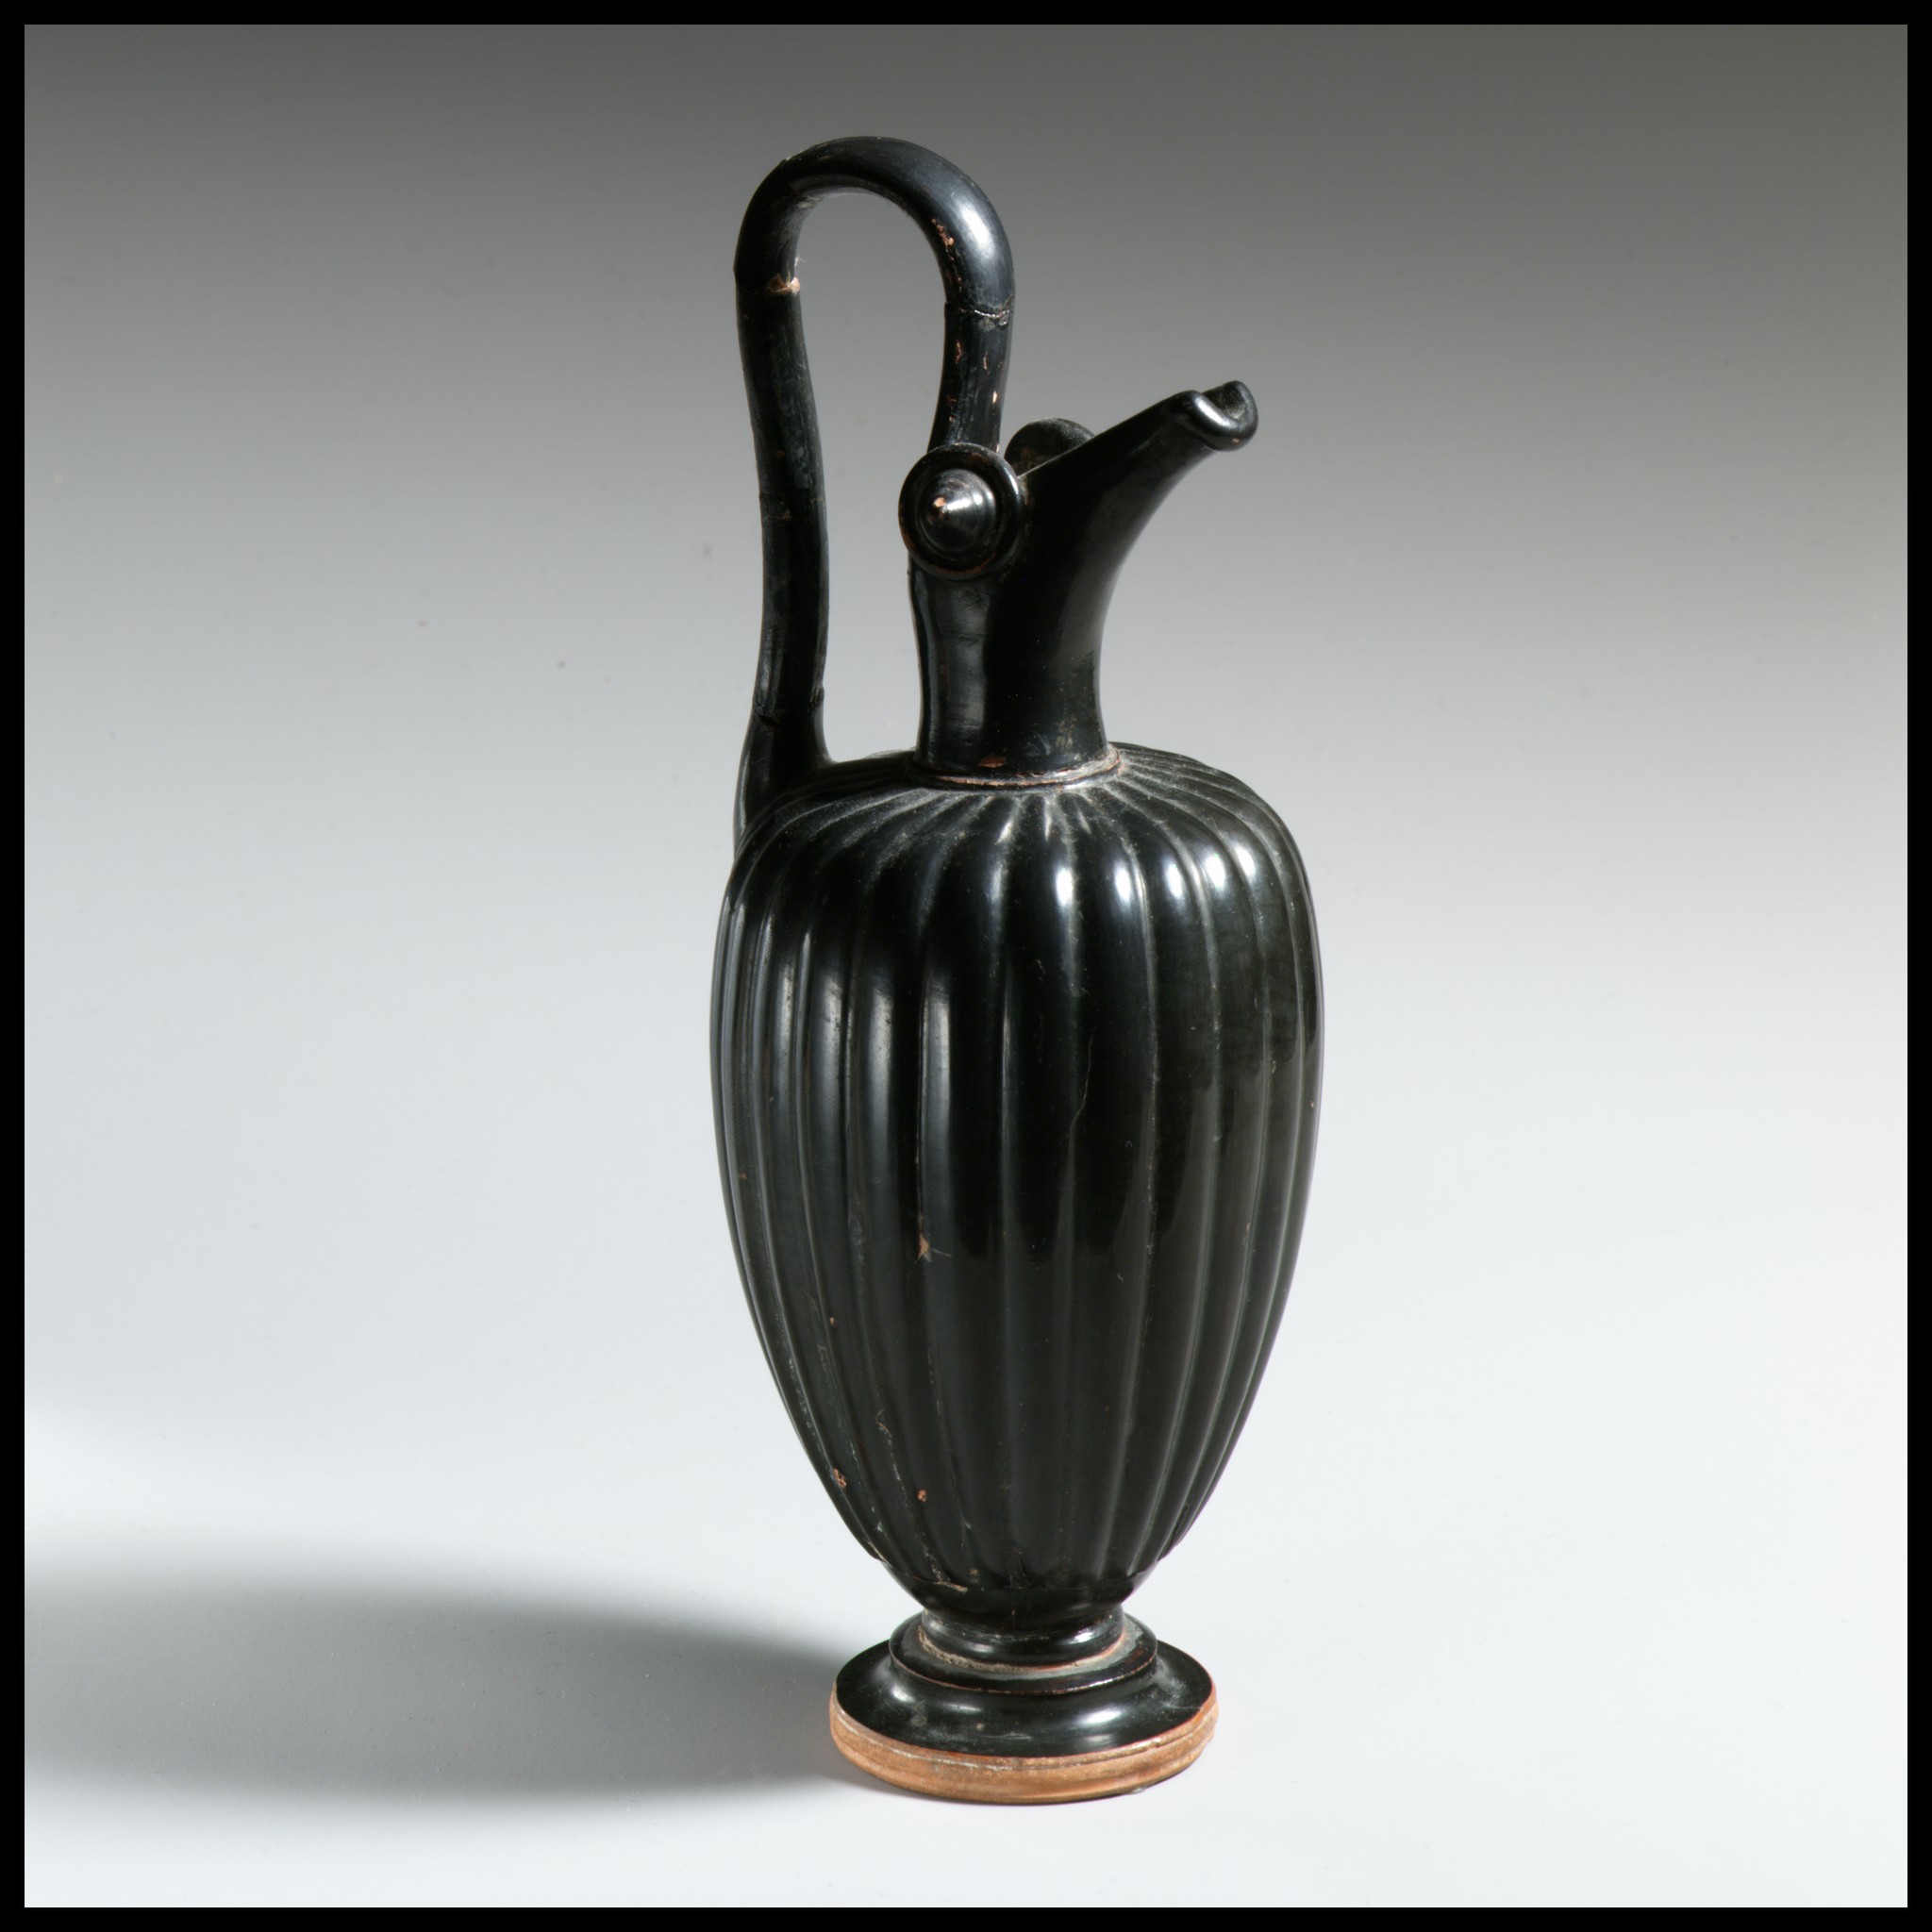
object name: oinochoe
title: Terracotta oinochoe (jug)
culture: greek or south italian or campanian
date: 400-301 BCE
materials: terracotta